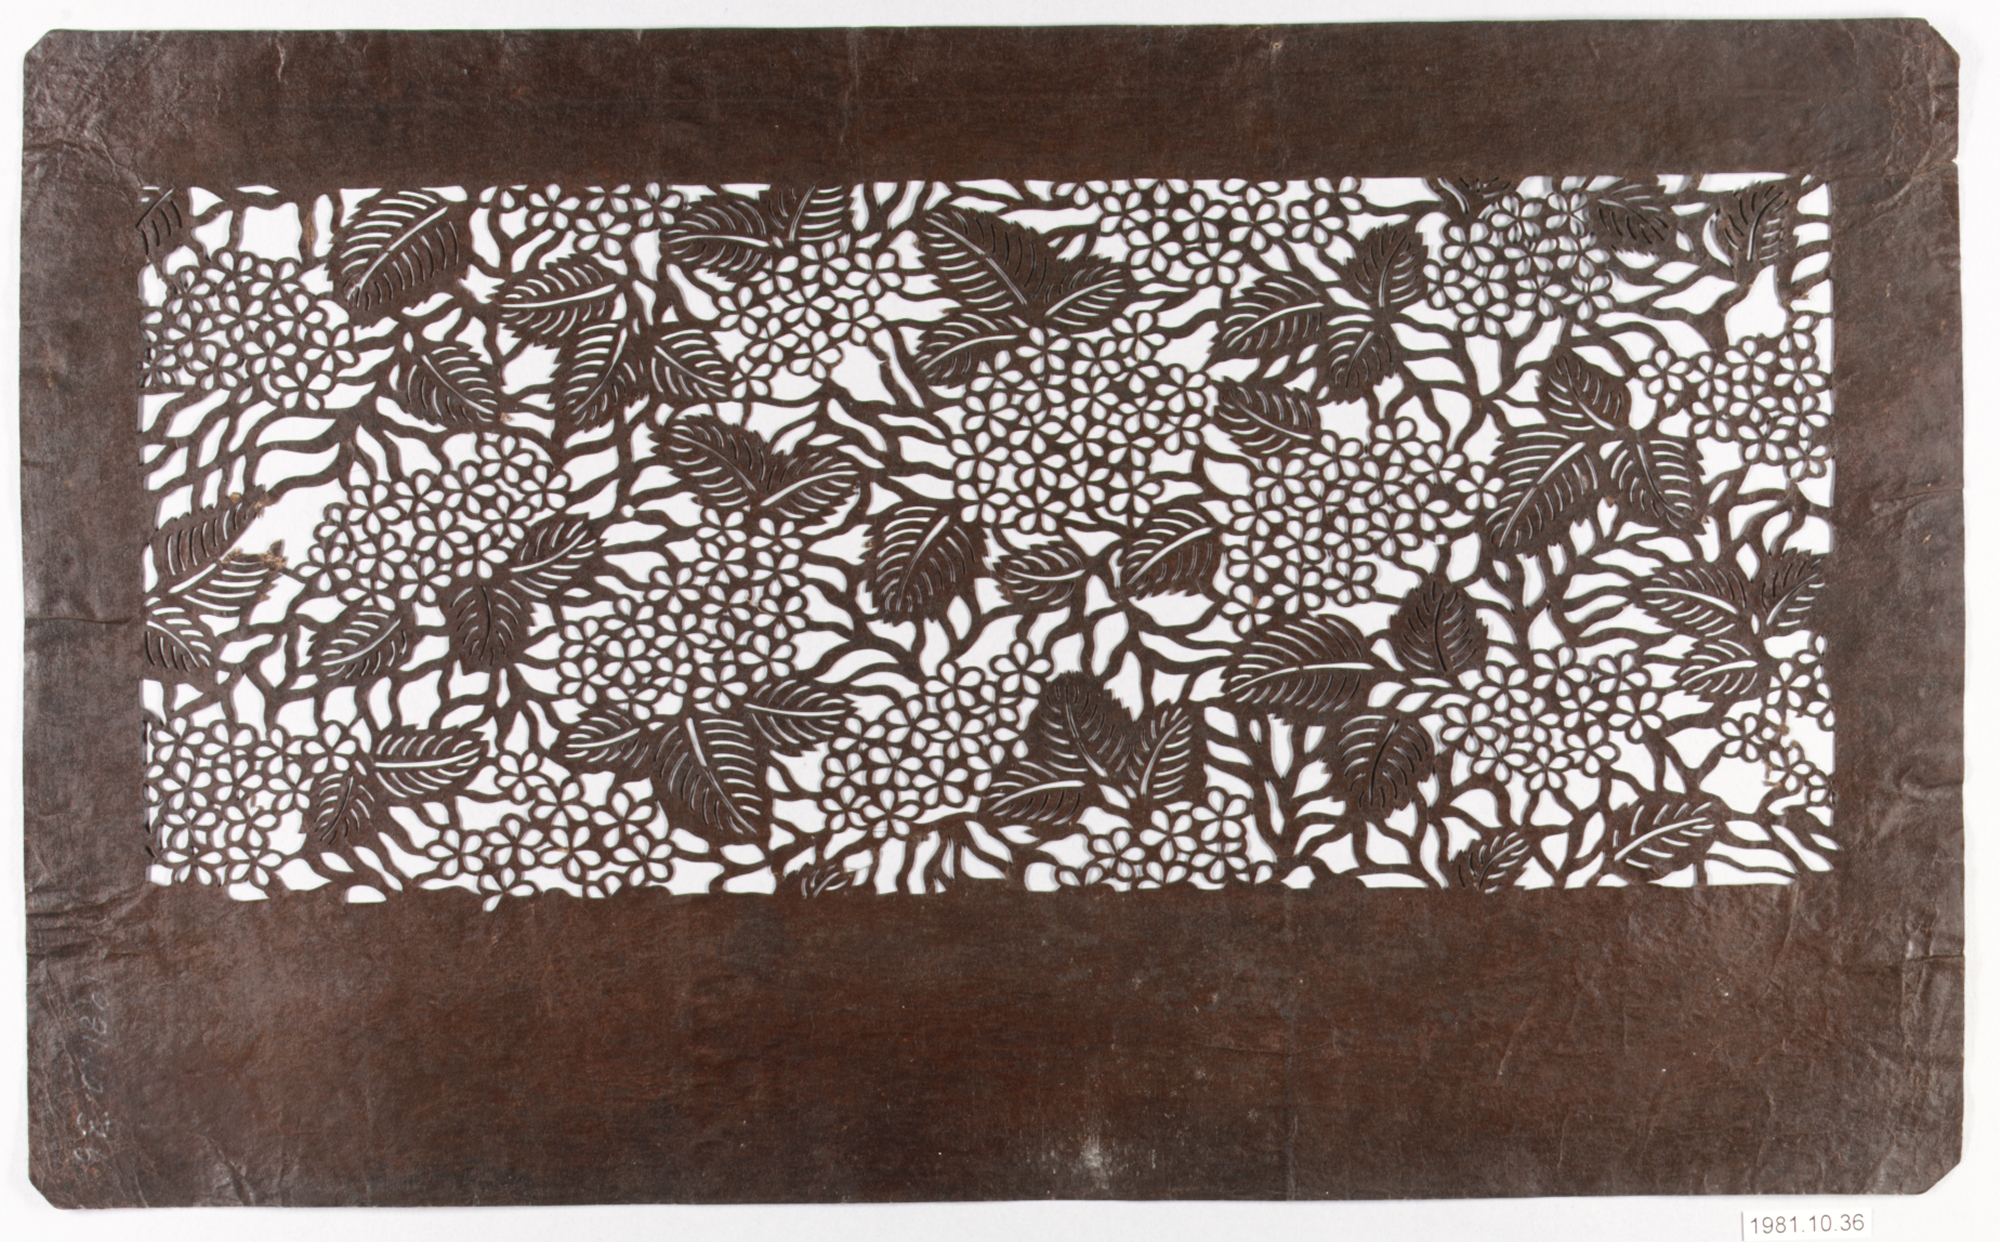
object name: stencil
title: Hydrangeas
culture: japanese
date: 1801-1900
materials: paper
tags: flowers